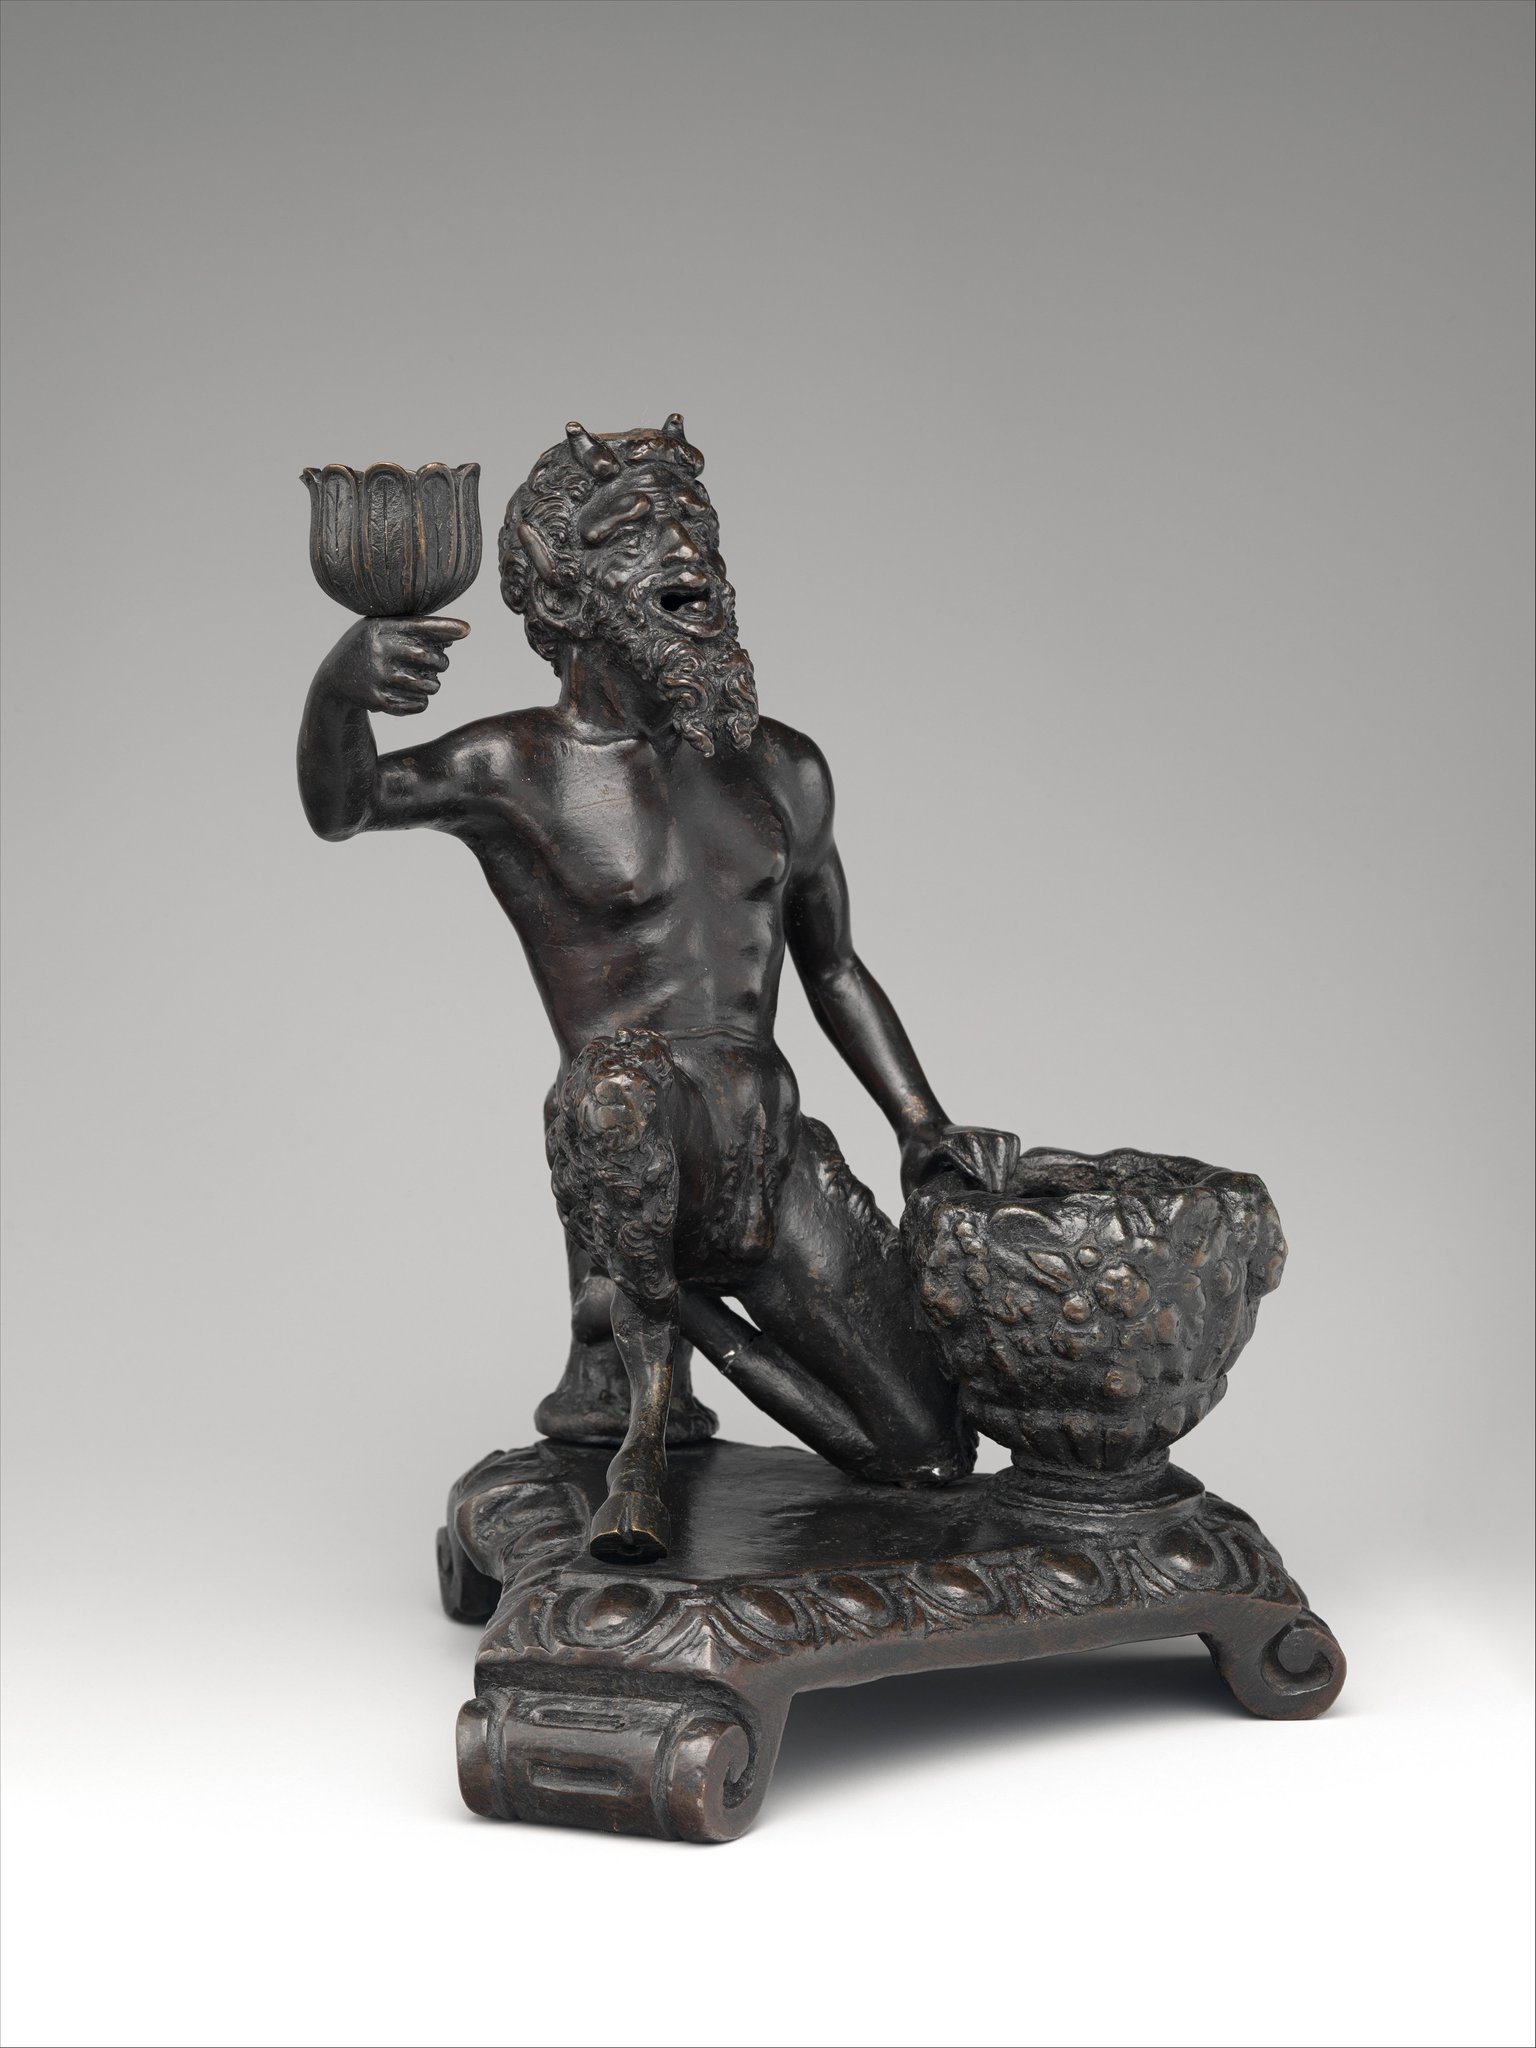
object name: statuette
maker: andrea briosco, called riccio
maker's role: artist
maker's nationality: italian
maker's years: 1470-1532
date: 1501-1600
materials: bronze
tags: centaurs